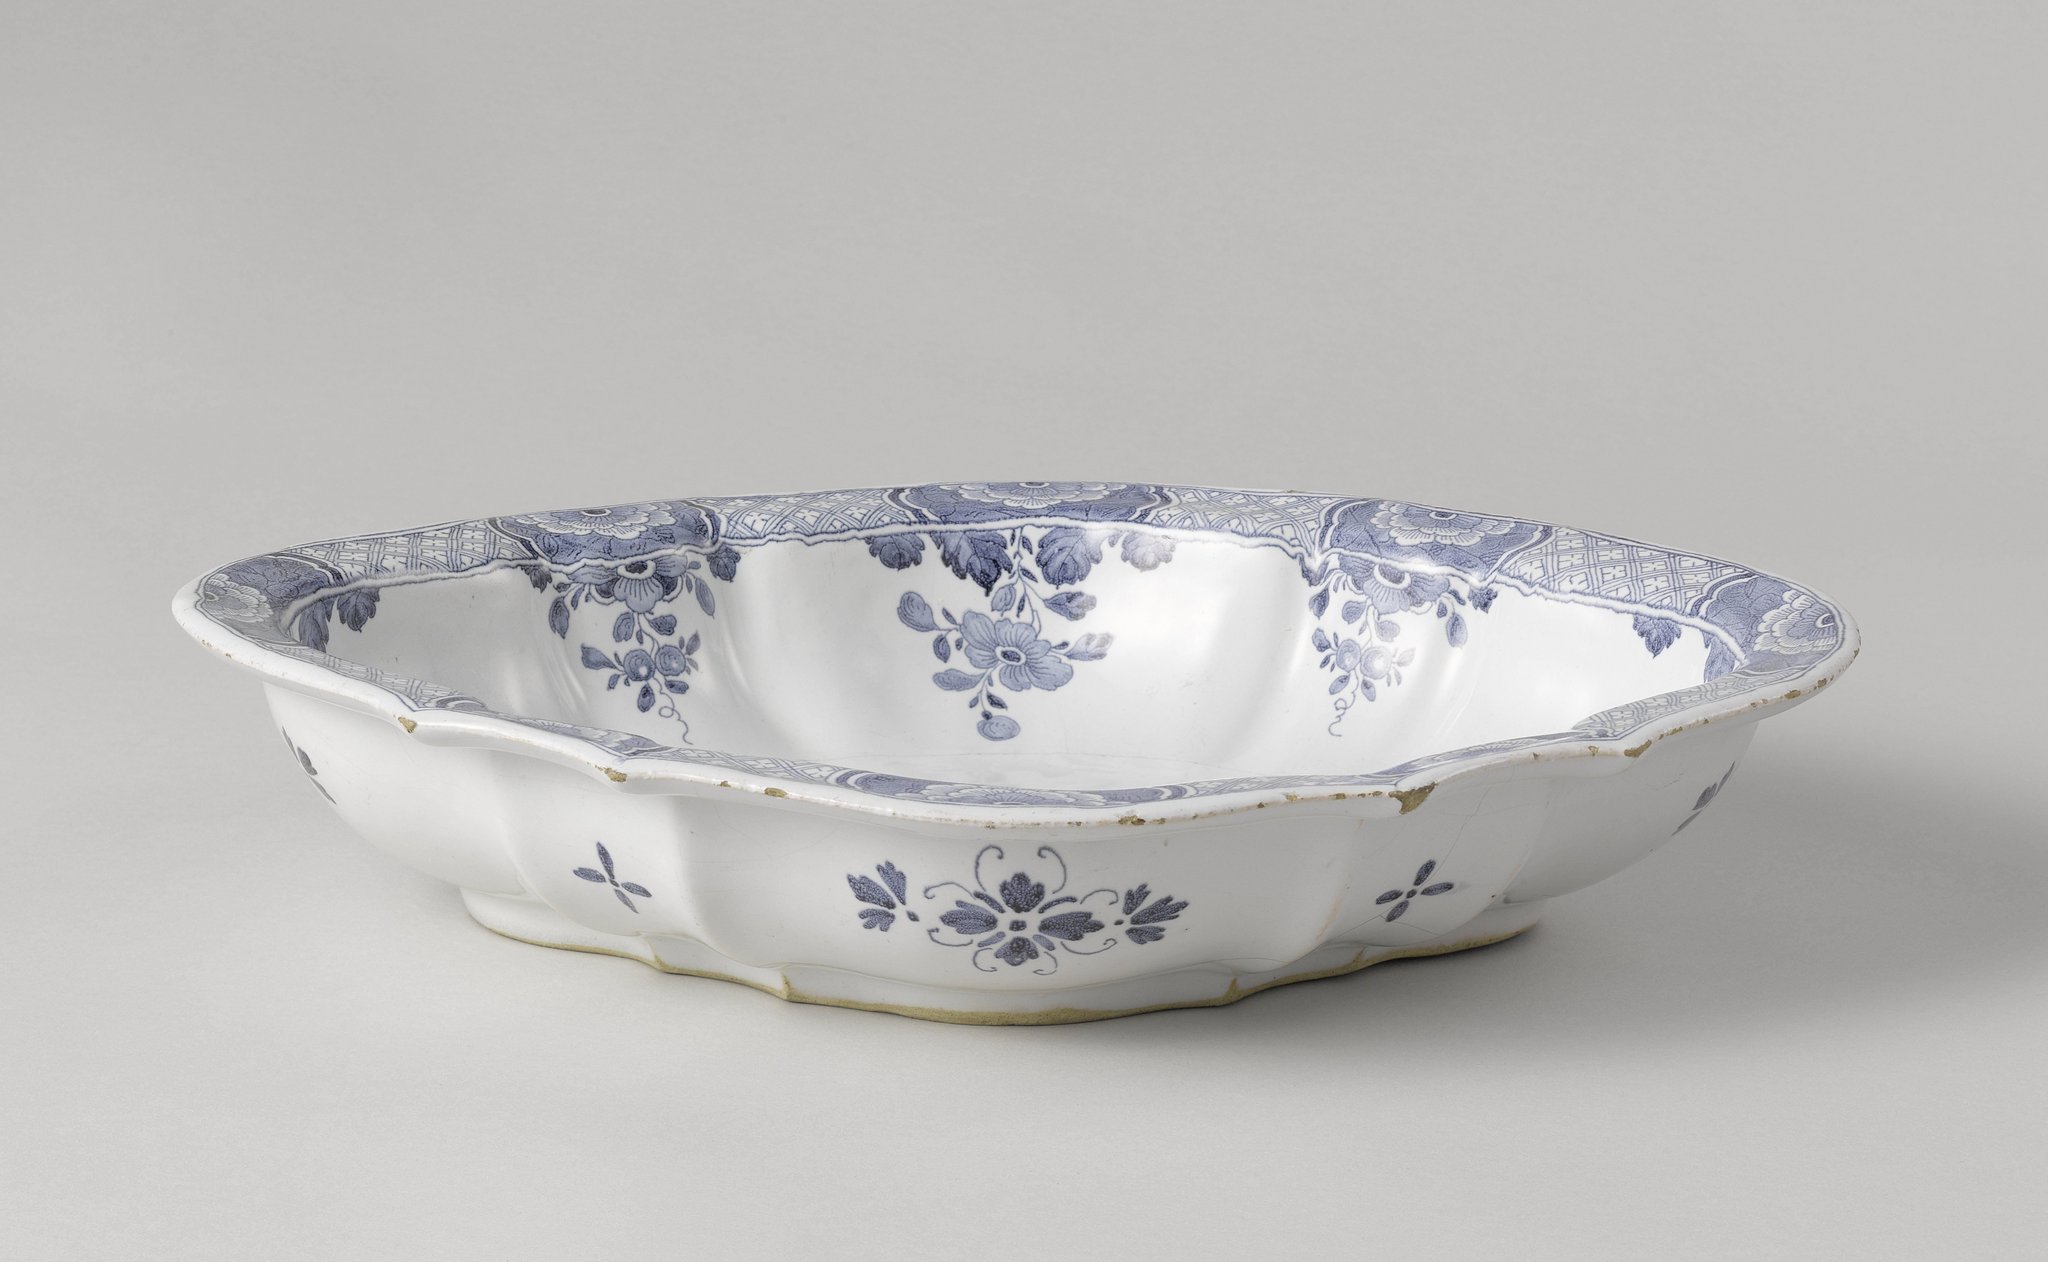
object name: salad bowl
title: Slakom, beschilderd in blauw met twee spelende kinderen bij een ruïne.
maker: johan van kerkhoff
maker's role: fayencier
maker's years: 1716-1773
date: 1760-1770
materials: faience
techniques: painted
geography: germany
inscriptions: mark: ‘figuratief teken haan’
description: Salad bowl. Faience with grand feu decoration. Arnhem, c. 1760 - 1770, factory of Johan van Kerckhoff. The couple under a tree on the bottom of the bowl after an engraving by Johann Elias Nilson from the series Caffe, The und Tabac-Zierathen (Coffee, Tea and Tobacco Ornaments).